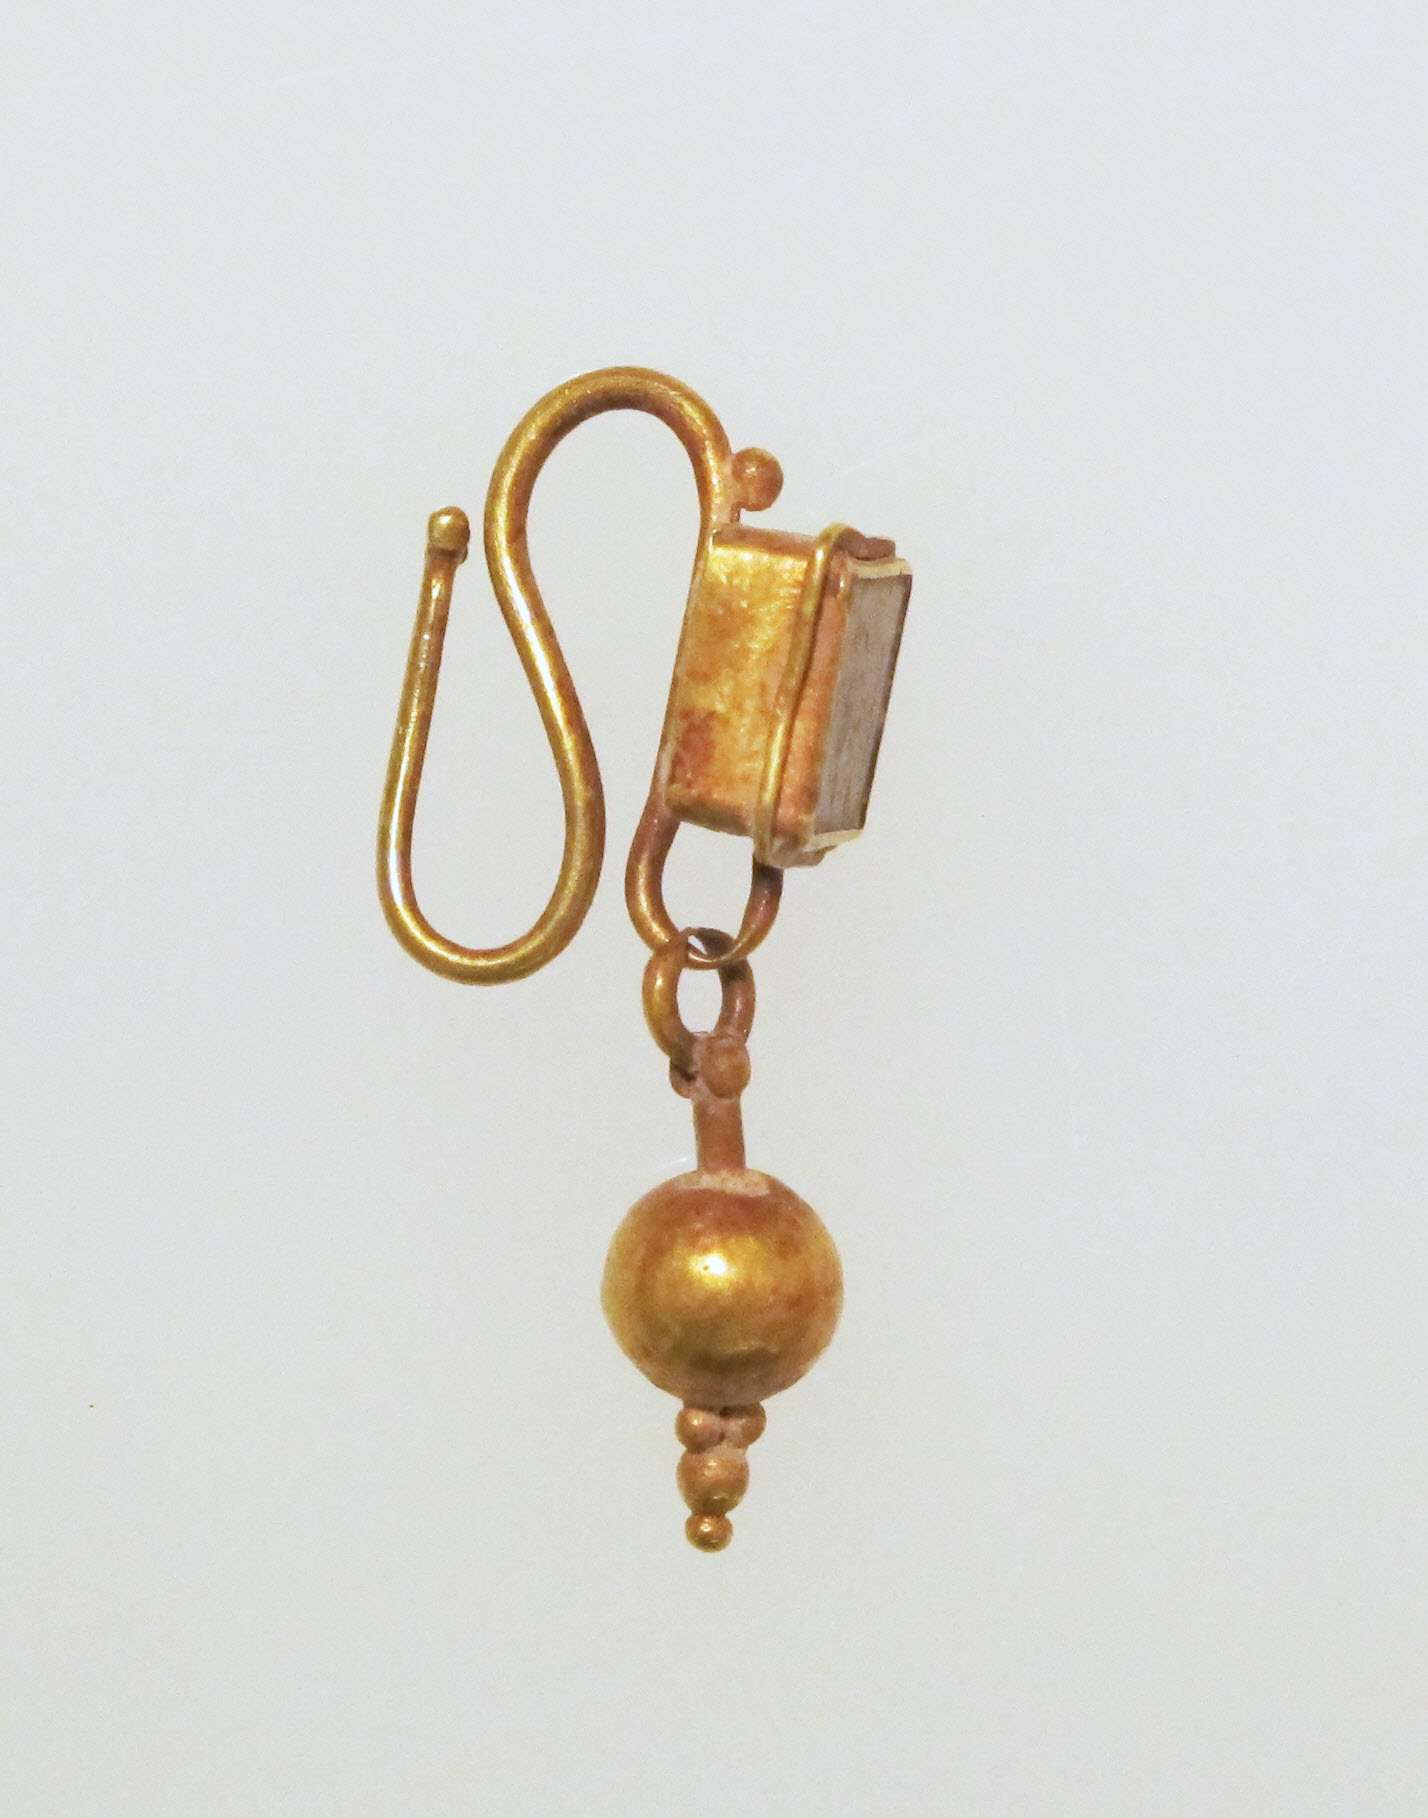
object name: earring hook type with ball pendant and paste setting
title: Earring-hook type with ball pendant and paste setting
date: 7000 BCE-330 CE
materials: glass, gold, paste